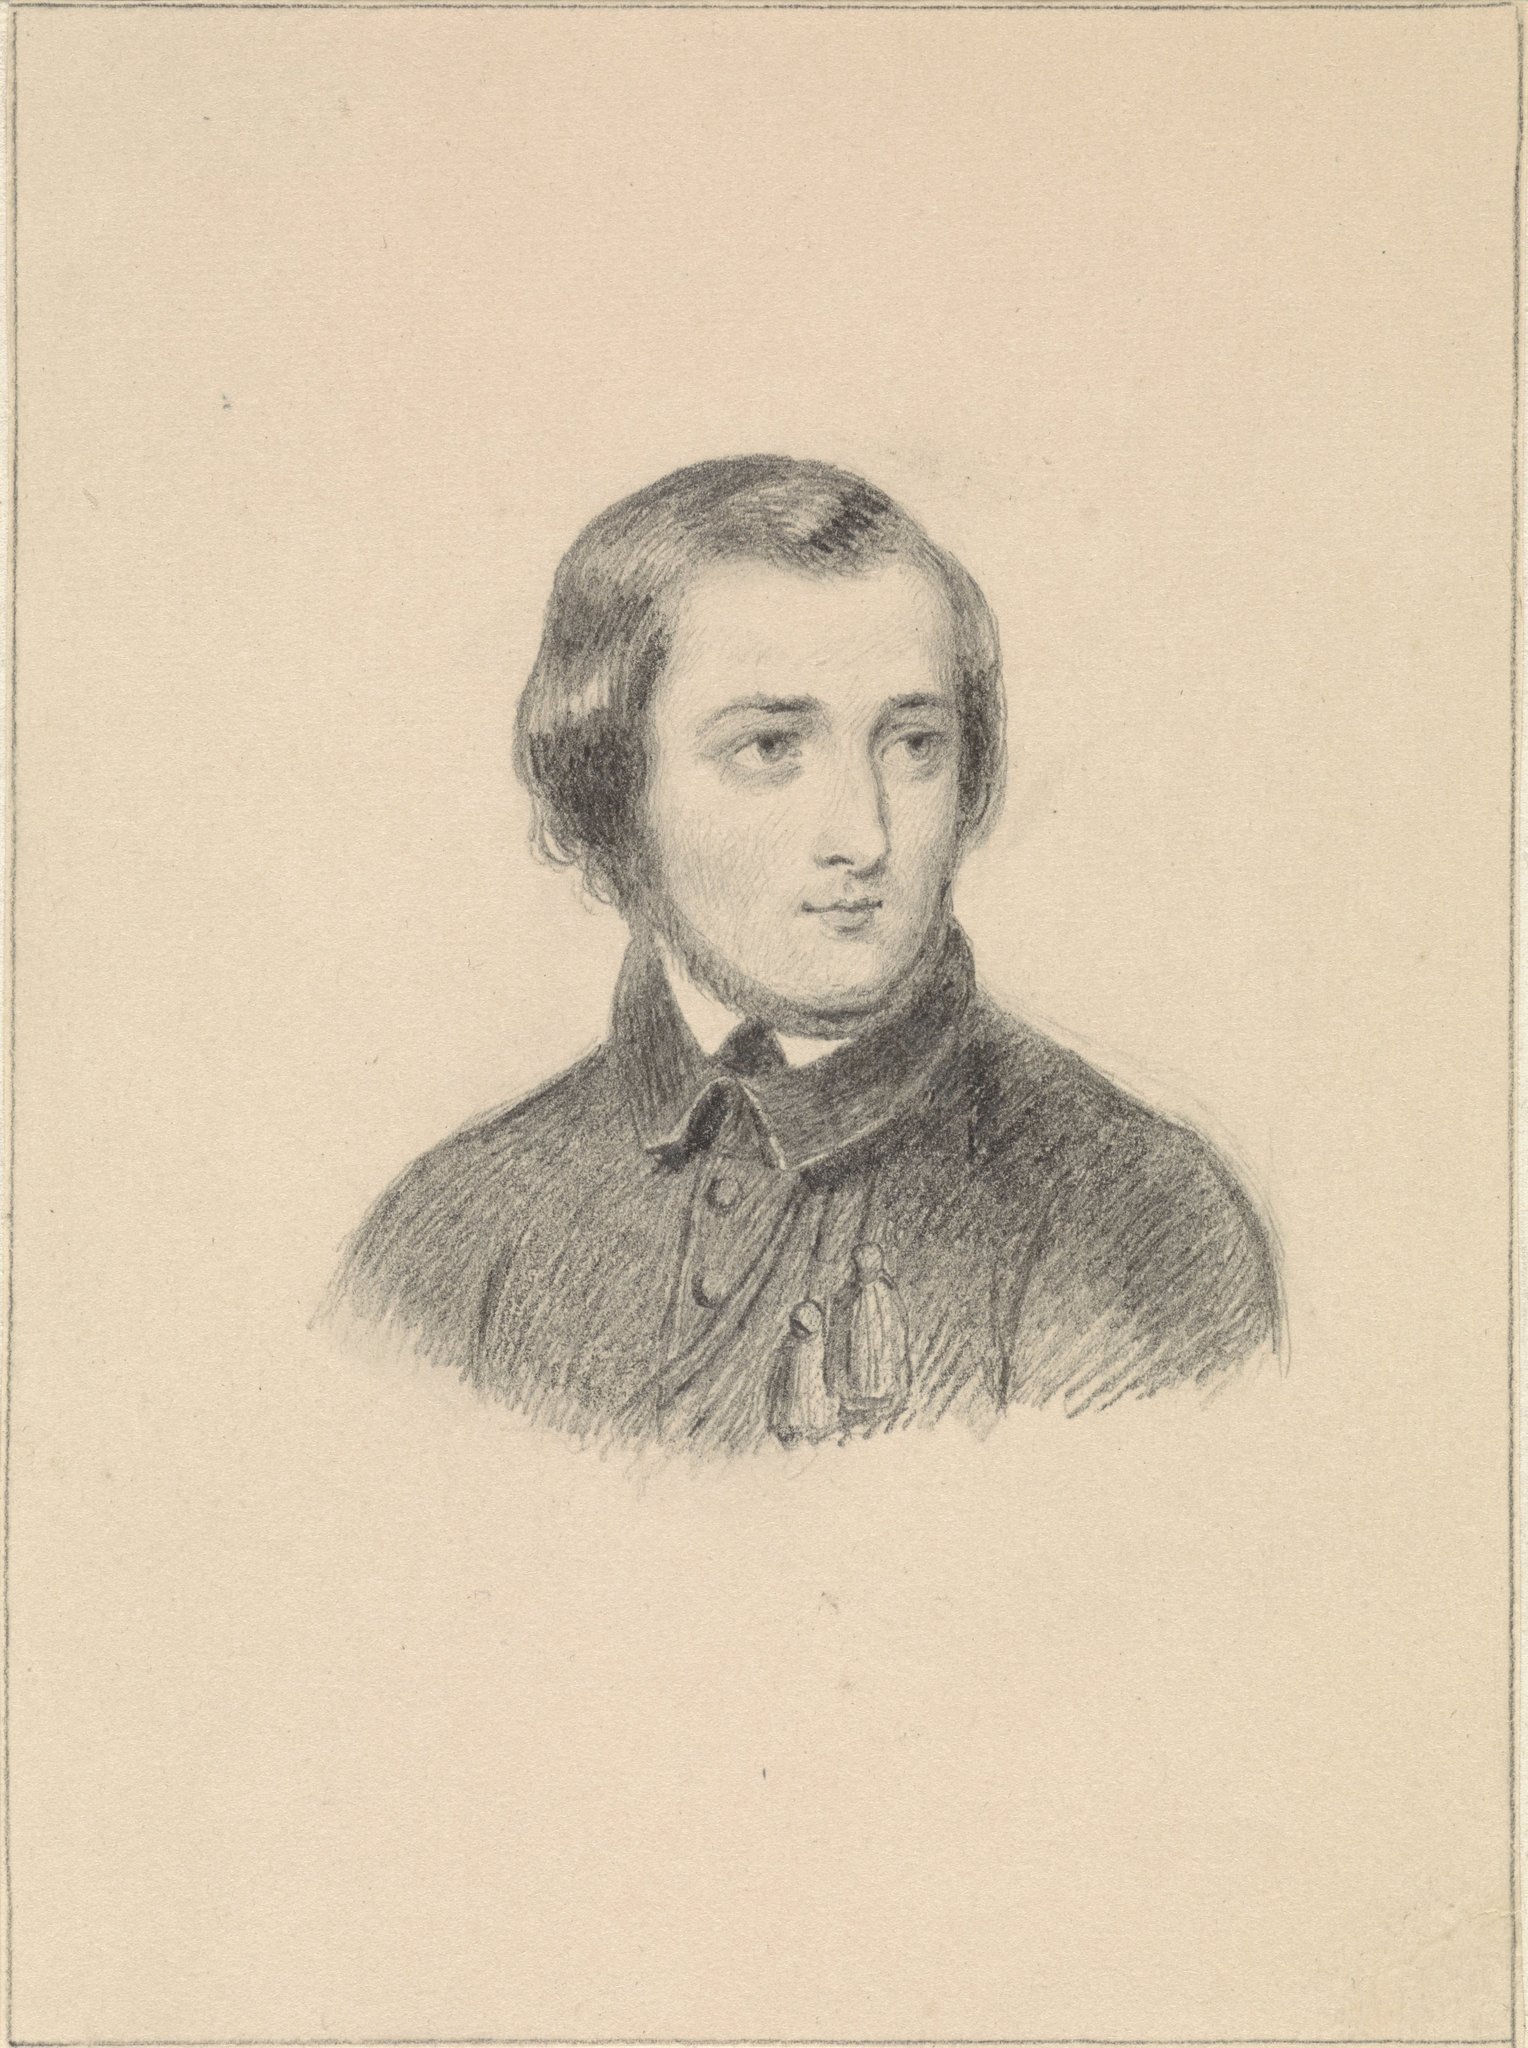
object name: design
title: Portret van Willem Geefs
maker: fanny geefs-corr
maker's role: draughtsman, painter, print maker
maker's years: 1807-1883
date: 1840-1842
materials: paper, pencil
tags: antwerp, willem geefs, historical persons, portrait, self-portrait of painter, portrait, self-portrait of artist, portrait, self-portrait of draughtsman